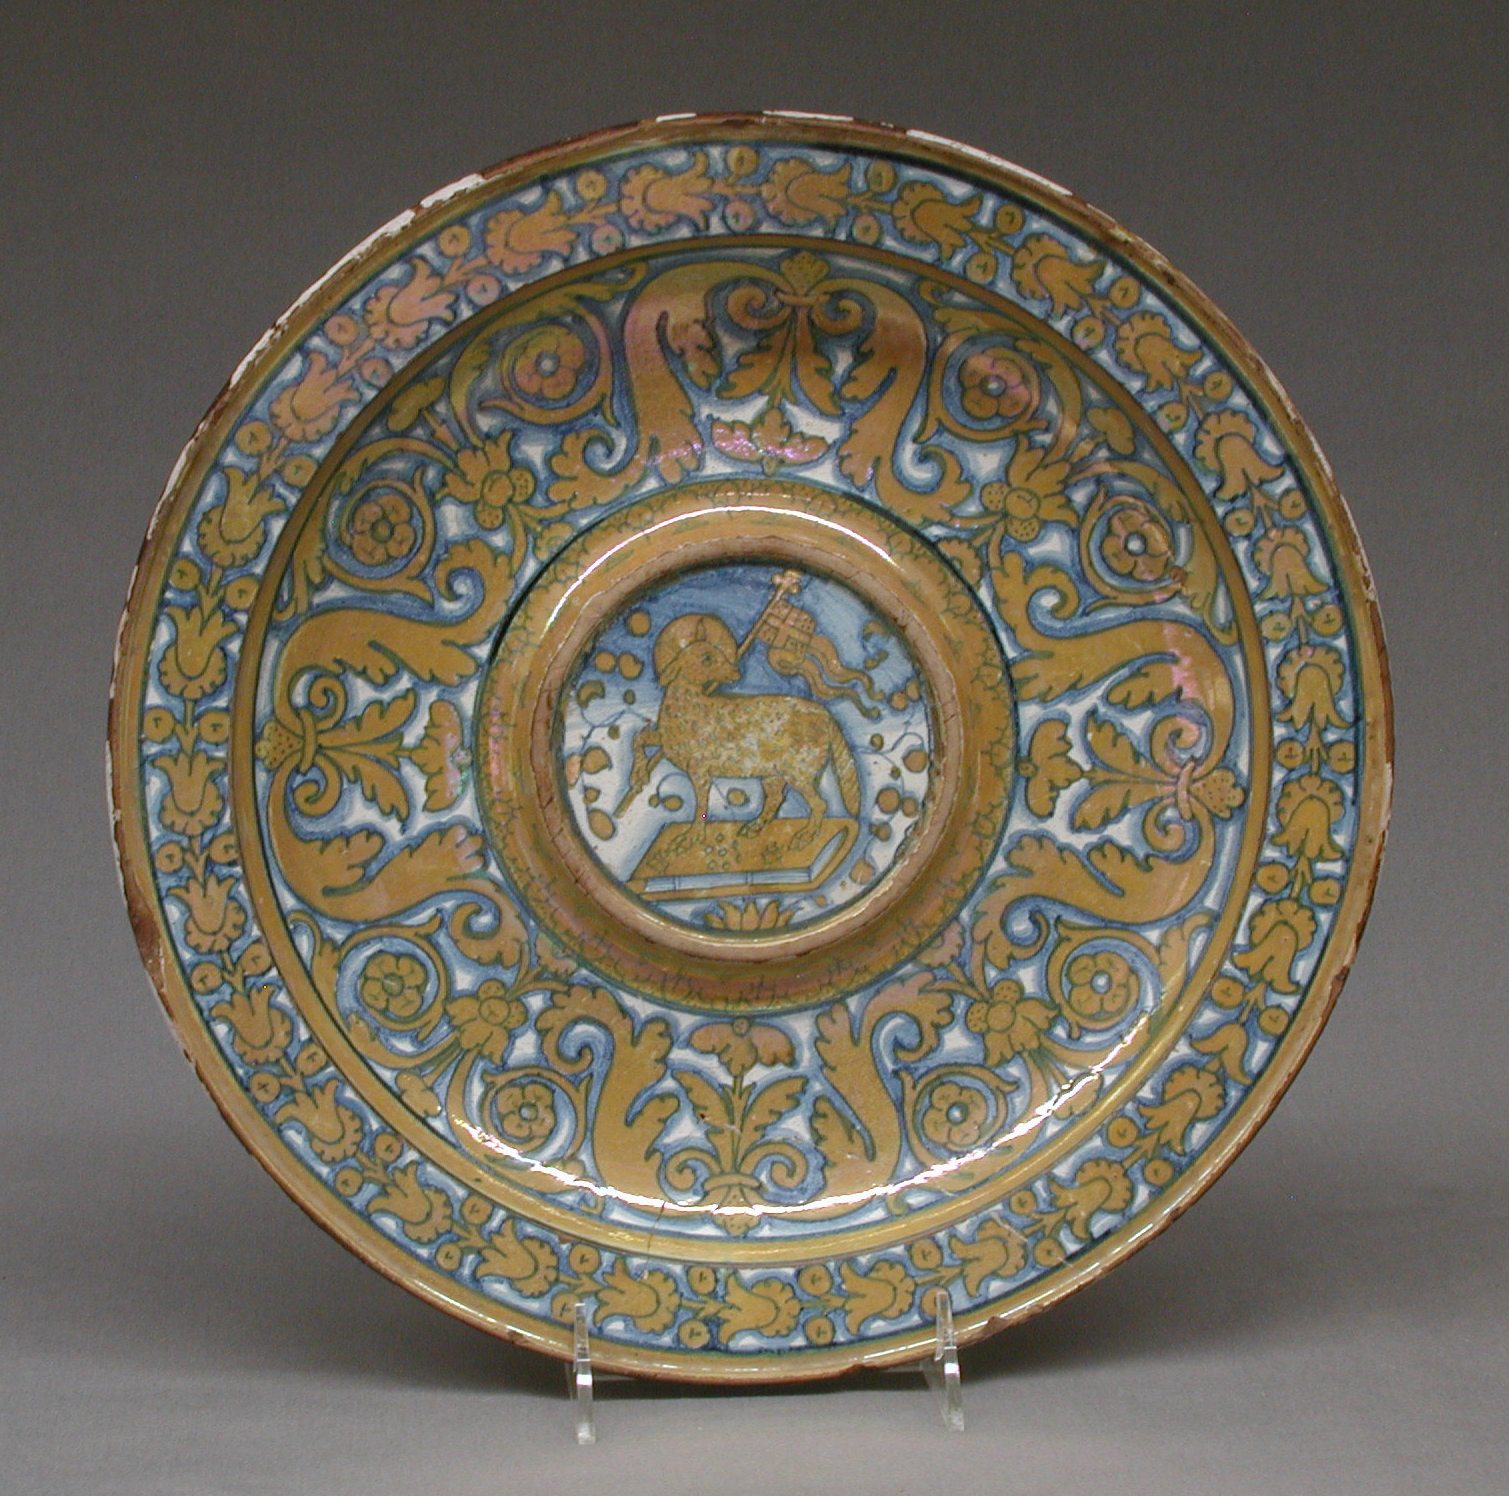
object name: ewer dish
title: Dish for an ewer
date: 1500-1520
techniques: maiolica, glazing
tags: animals,flags